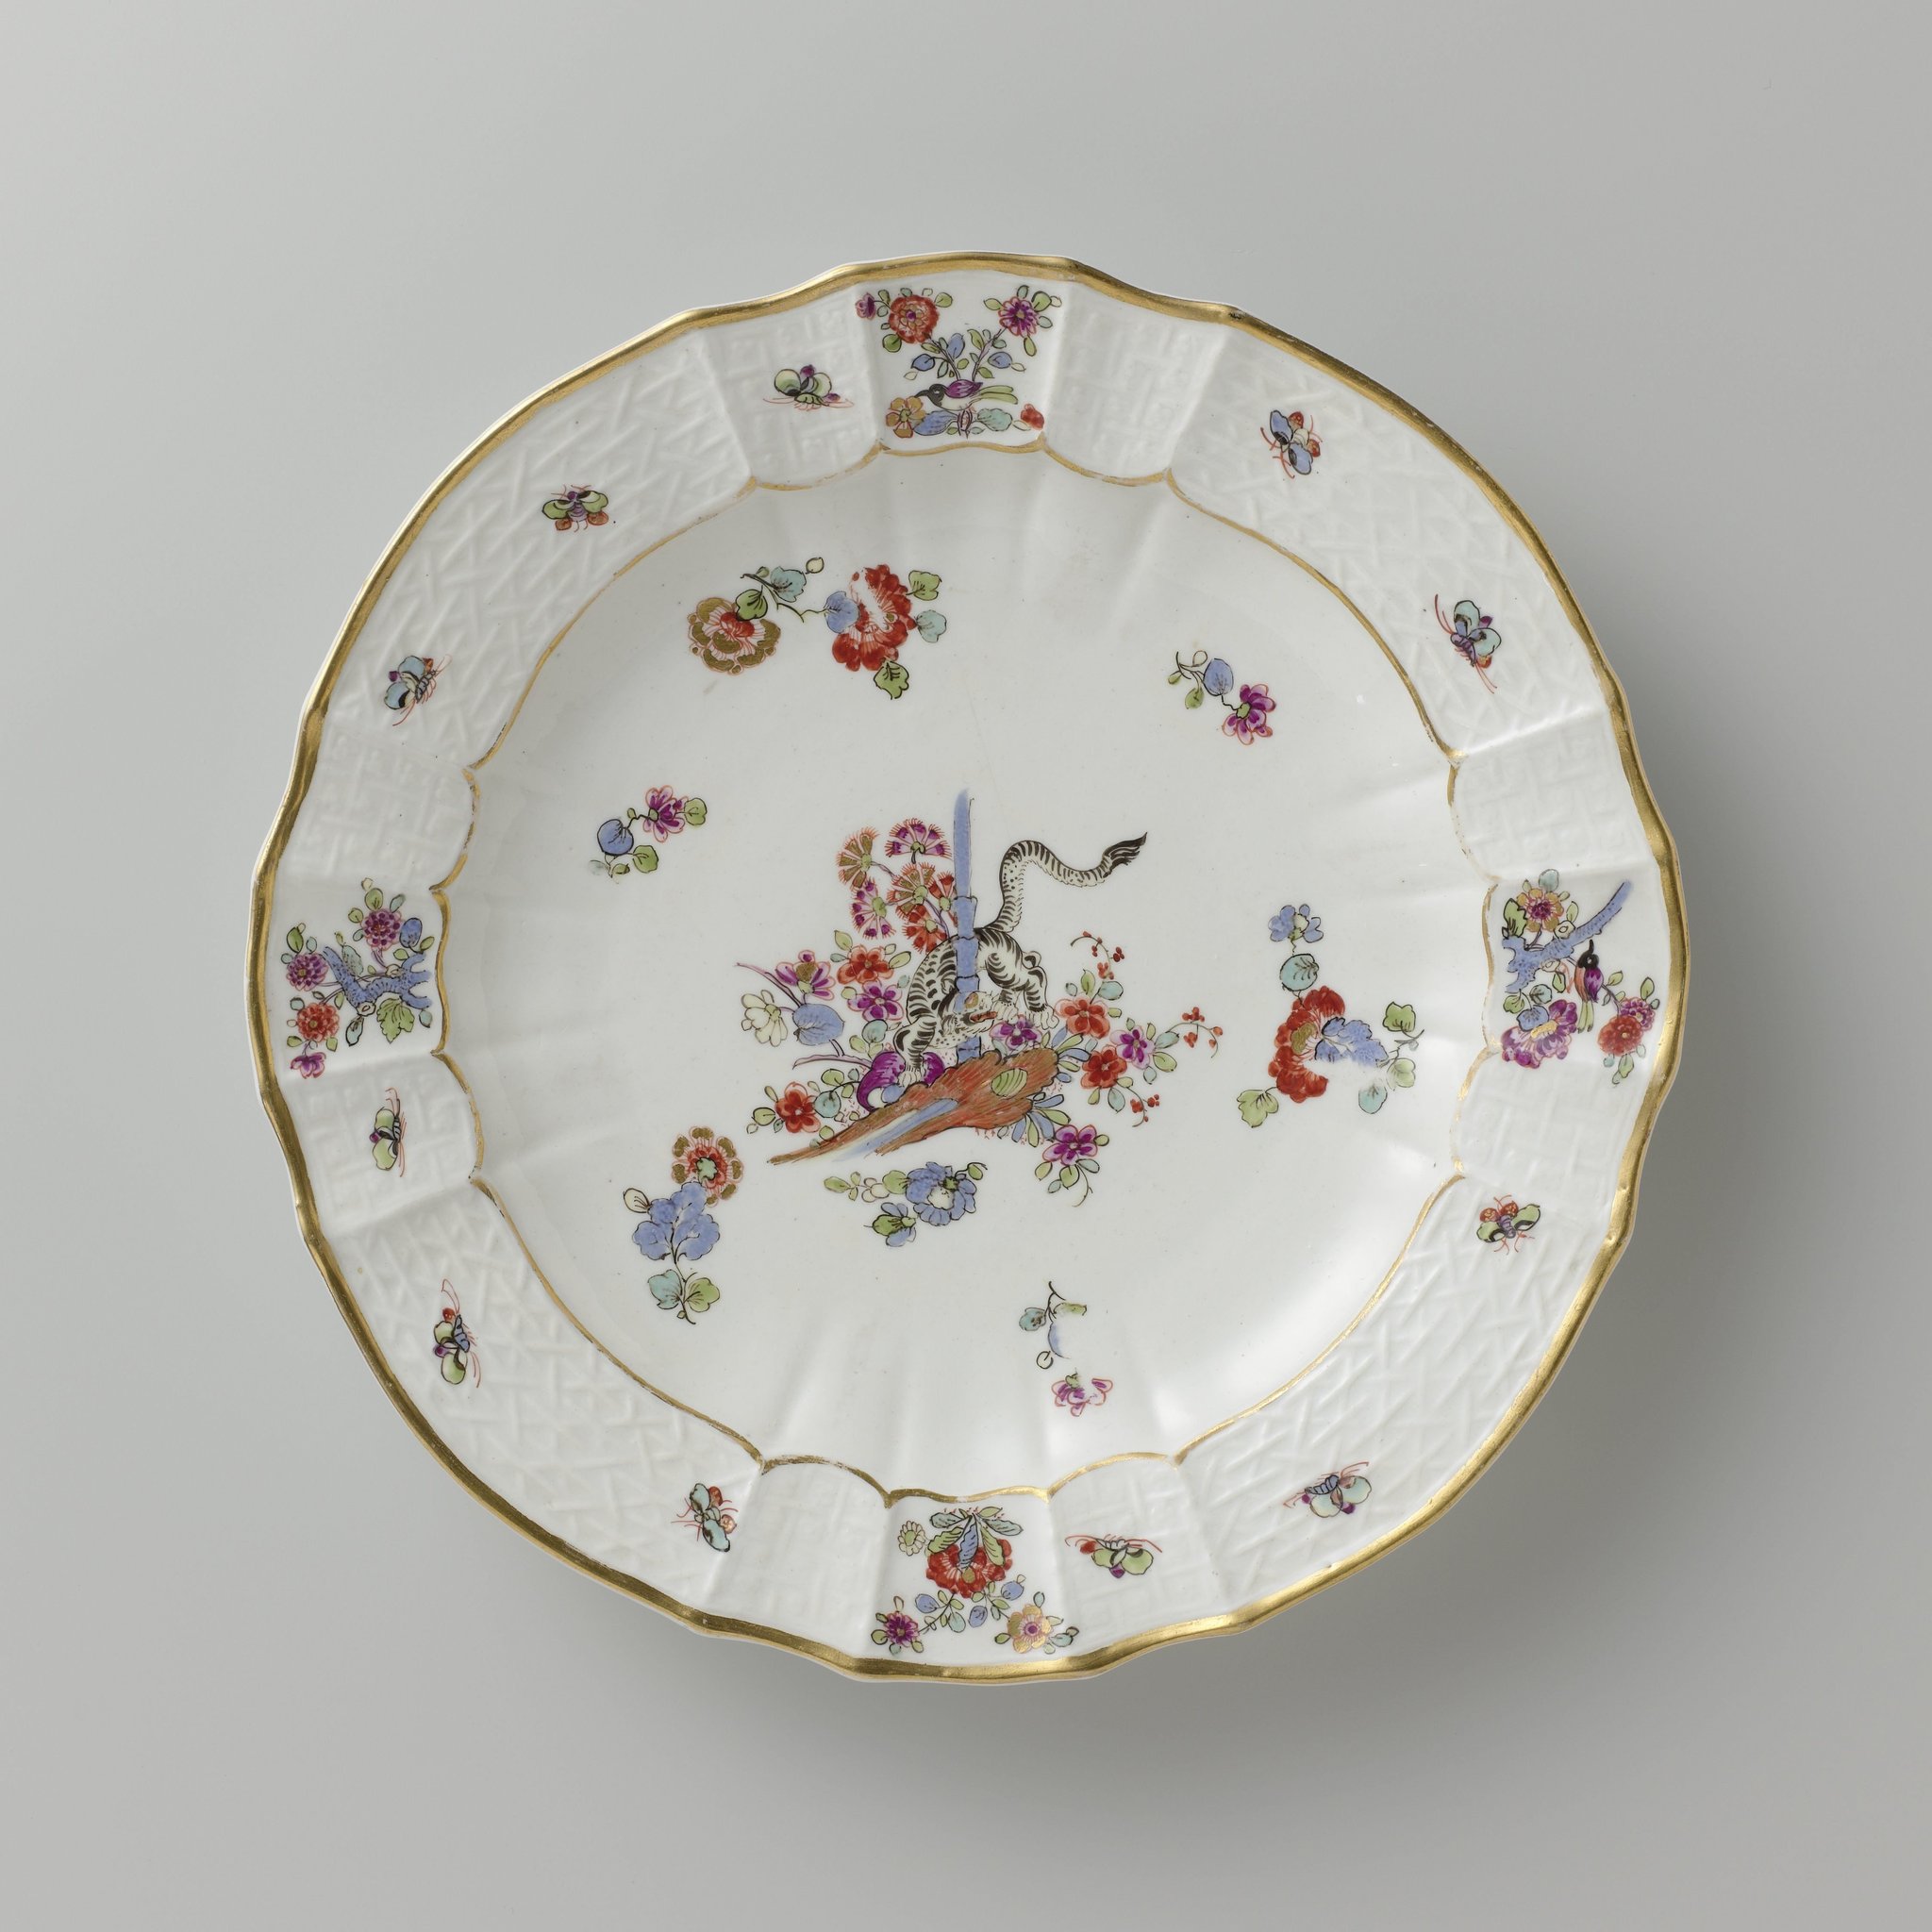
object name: plate dish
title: Rond bord, veelkleurig beschilderd met een Kakiemon-decor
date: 1740-1745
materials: porcelain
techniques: painted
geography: meissen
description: Rond bord van beschilderd porselein. Het bord is geribd en heeft een geschulpte rand. Het bord is beschilderd met een tijger die om een blauwe bamboestengel tussen bloemen is gedraaid, gestrooide Indianische Blumen, vlinders en takken waarop vogels. De rand is versierd met het 'Altbrandenstein'-patroon. Het bord is gemerkt.